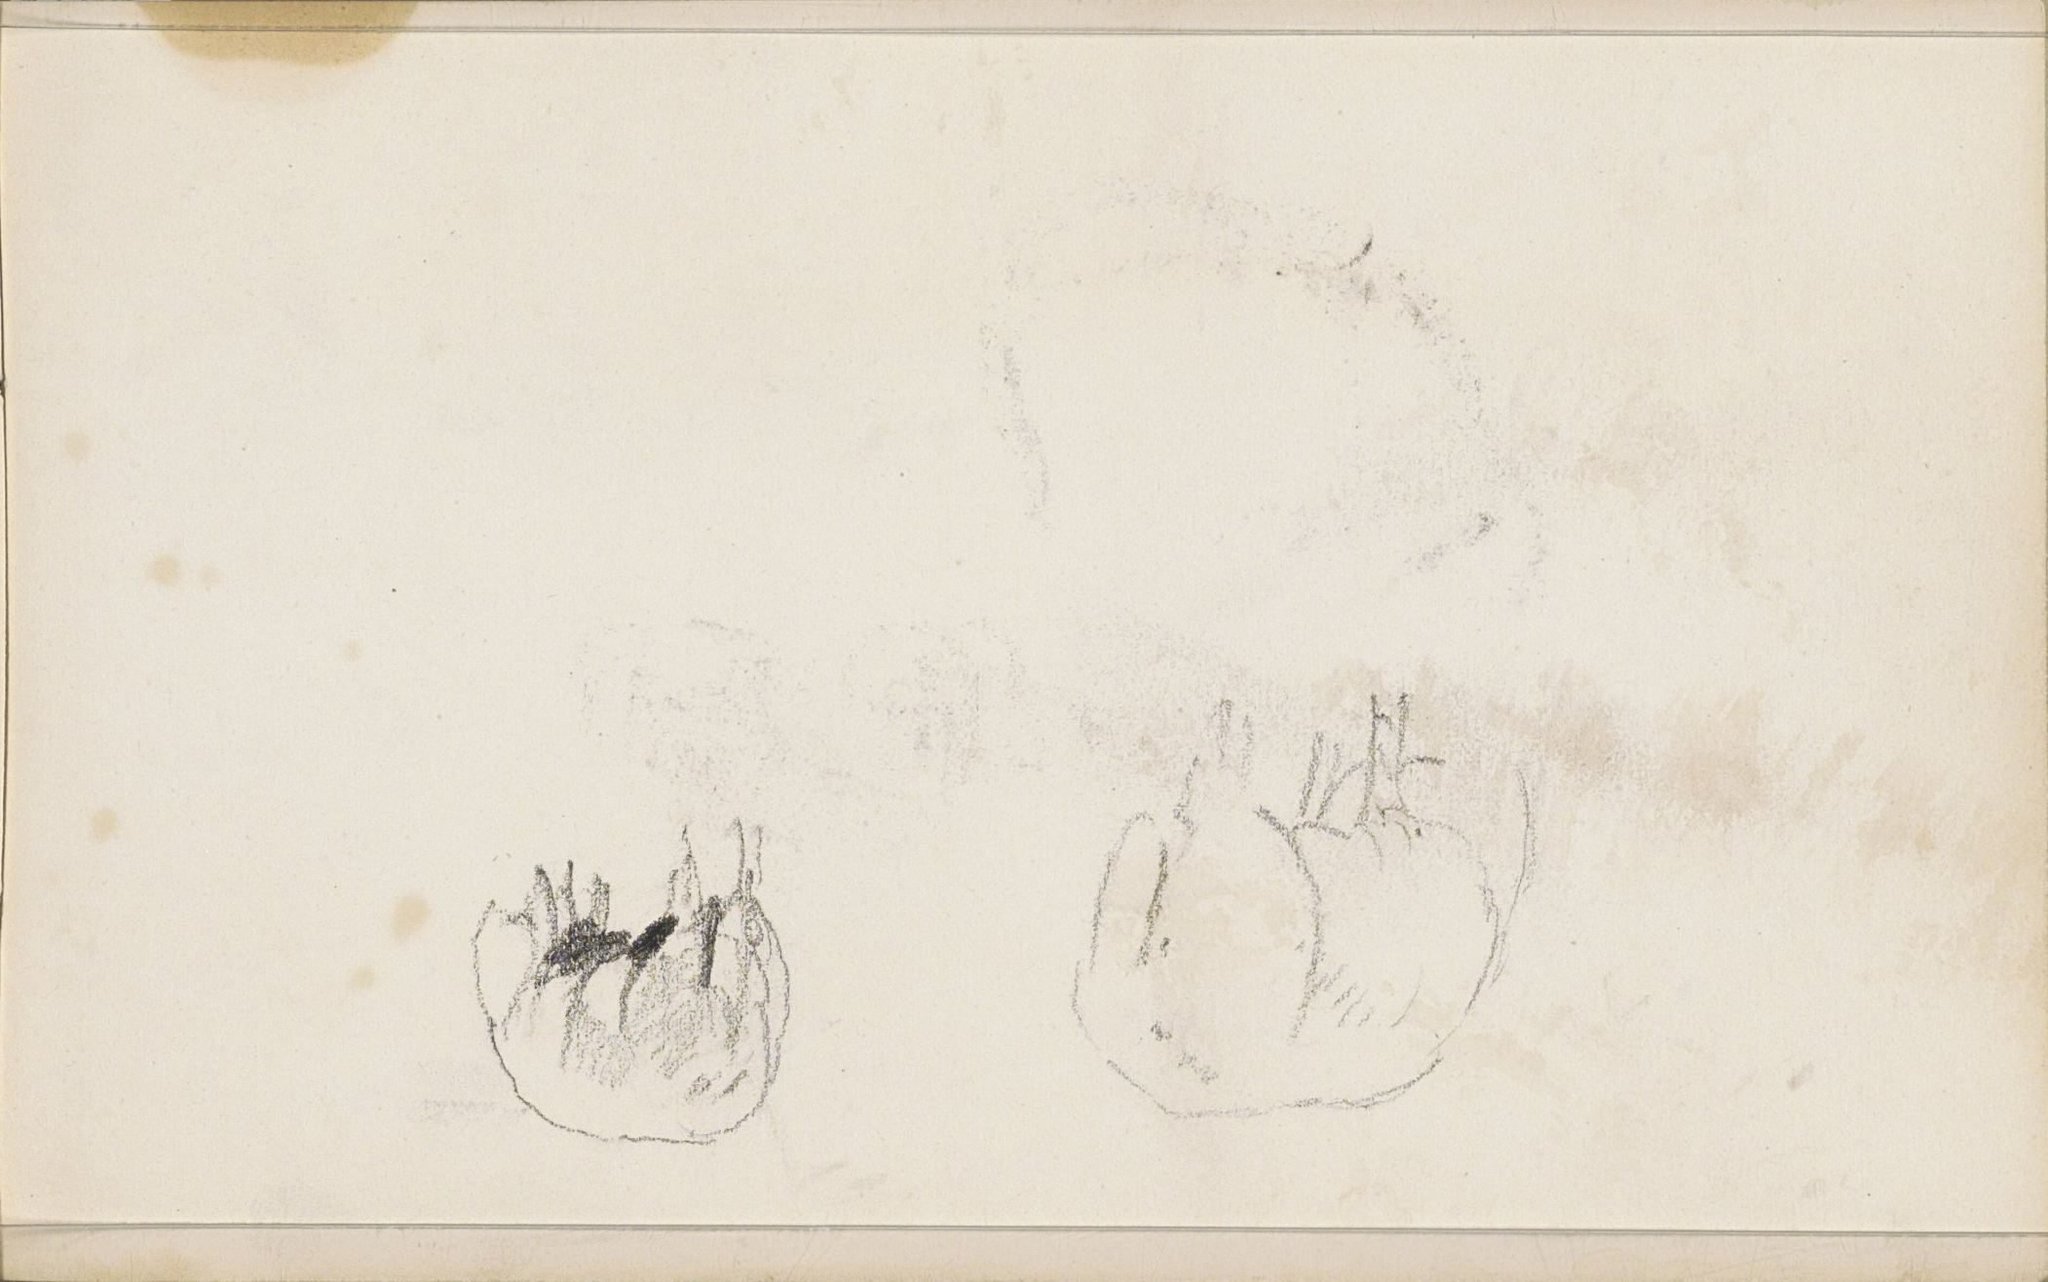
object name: sketchbook leaf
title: Twee grazende schapen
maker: anton mauve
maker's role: draughtsman, painter, print maker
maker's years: 1838-1888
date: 1848-1888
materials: paper, pencil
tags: sheep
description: Blad 33 recto uit een schetsboek met 44 bladen.